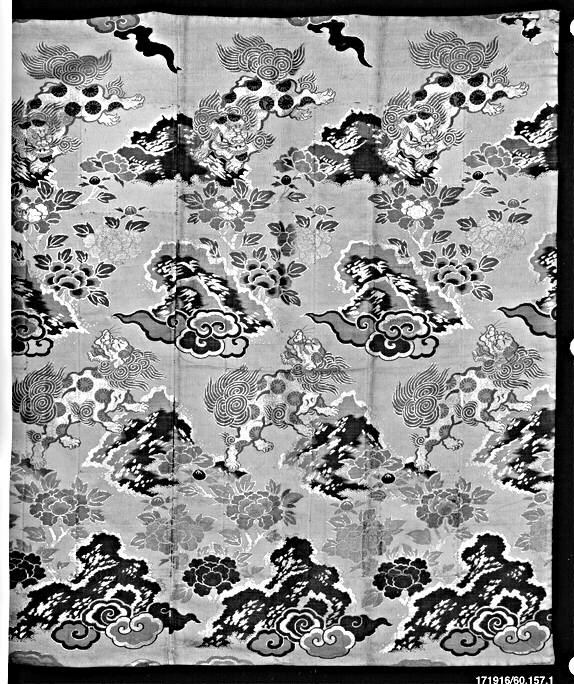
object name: robe, priest's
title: Priest's Robe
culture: japanese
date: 1801-1833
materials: metal thread, silk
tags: animals